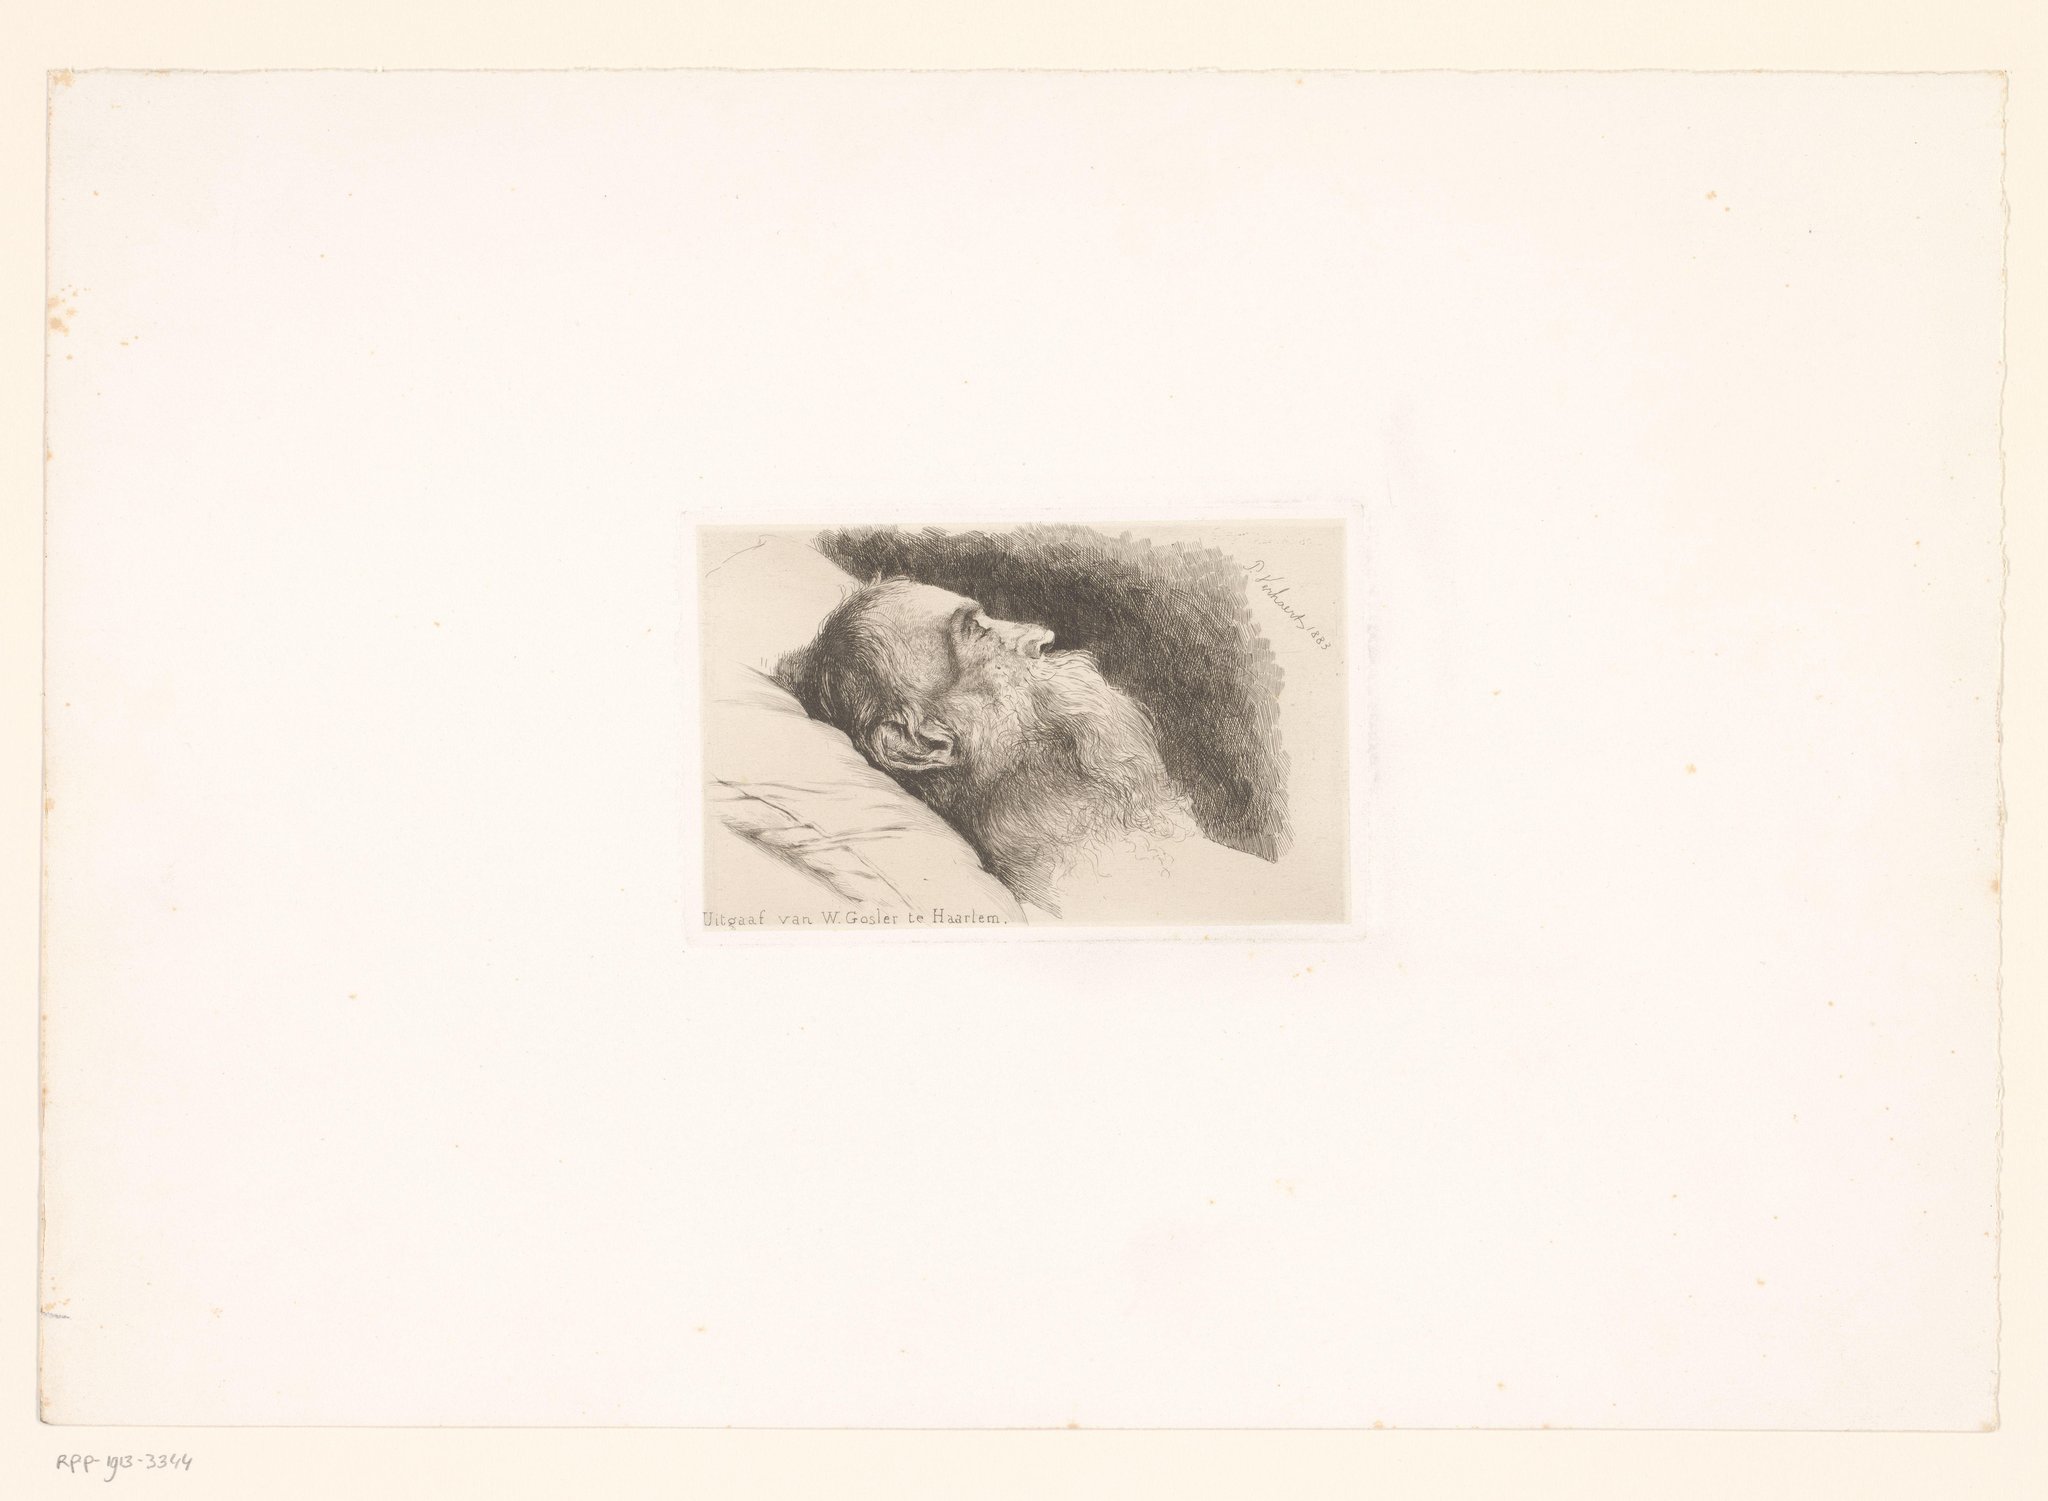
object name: print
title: Hendrik Conscience op zijn doodsbed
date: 1883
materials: paper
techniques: etching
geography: haarlem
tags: antwerp, deathbed, historical persons, beard, lying in state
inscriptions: collector's mark: Lugt 2228